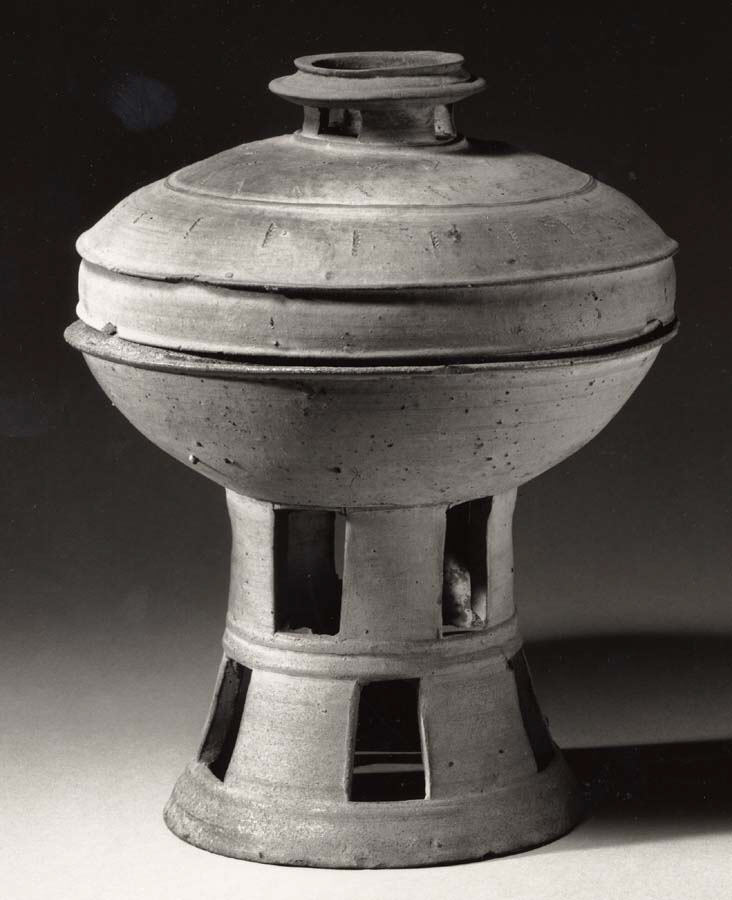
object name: pedestal dish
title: Pedestal dish with cover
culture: korean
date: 401-600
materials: stoneware